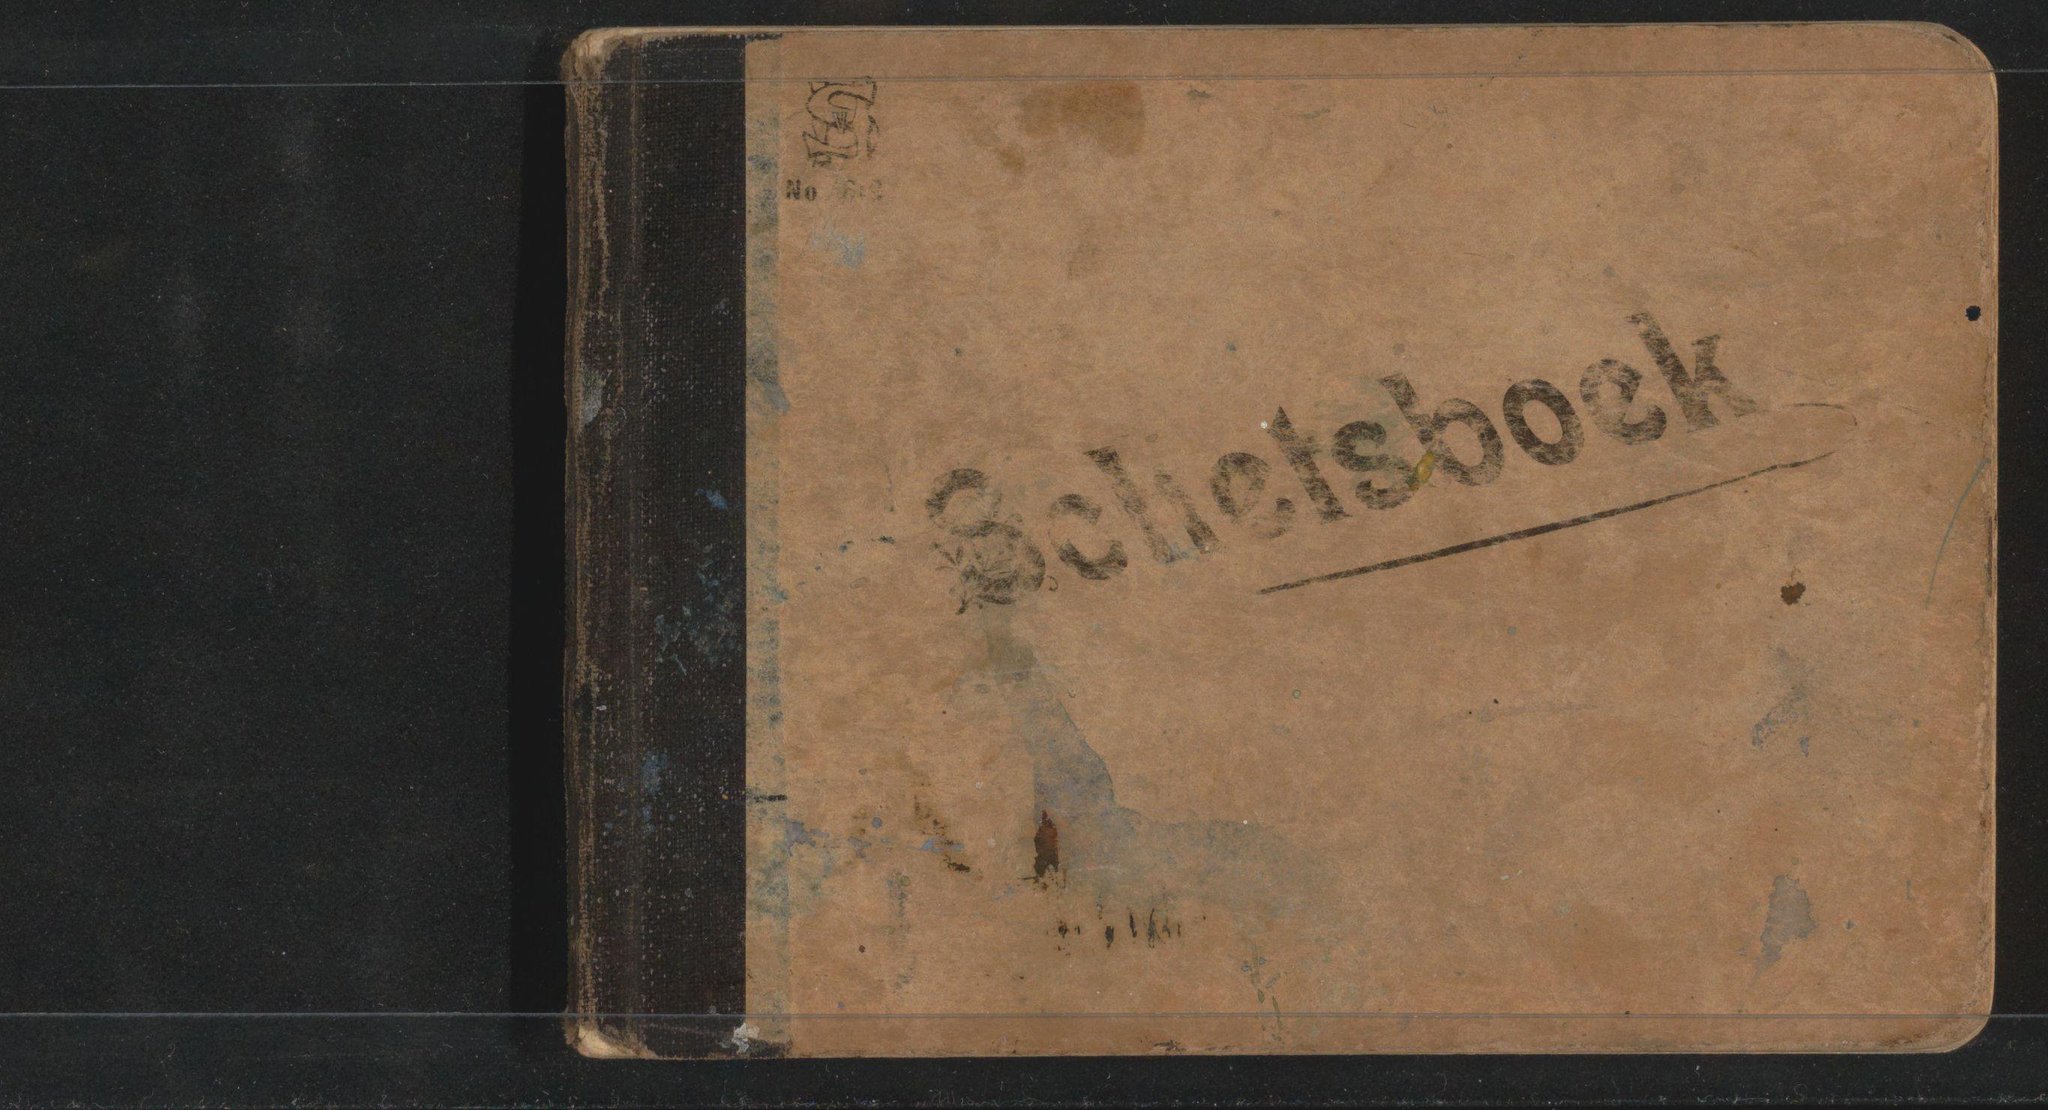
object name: sketchbook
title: Schetsboek met 42 bladen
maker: willem cornelis rip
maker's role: draughtsman, painter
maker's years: 1856-1922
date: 1866-1922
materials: cardboard, chalk, ink, linen, paper, pencil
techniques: brush, pen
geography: north brabant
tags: landscapes with waters, waterscapes, seascapes (in the temperate zone), village, windmill in landscape, farm (building), oostvoorne, brielle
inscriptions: factory mark: ‘SvH/ No. [...]’, retailer's mark: ‘TH.J.DE KONING/ Kantoor-/ en Papierhandel/ PASSAGE 36-38-39’, signature and address: ‘Willem c Rip/ den Haag’, annotation: ‘H. Reinhardt/ Chicago/ Hotel Kurhaus/ A. Duey/ St Loui[...]/ [...]’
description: Schetsboek bestaande uit 42 bladen met landschappen met en zonder bebouwing, onder andere bij en van Oostvoorne, Zwartewaal, Den Briel, Dommelen, Leende, Waalre, Boekel, Arkel, Valkenswaard en Ravenstein.